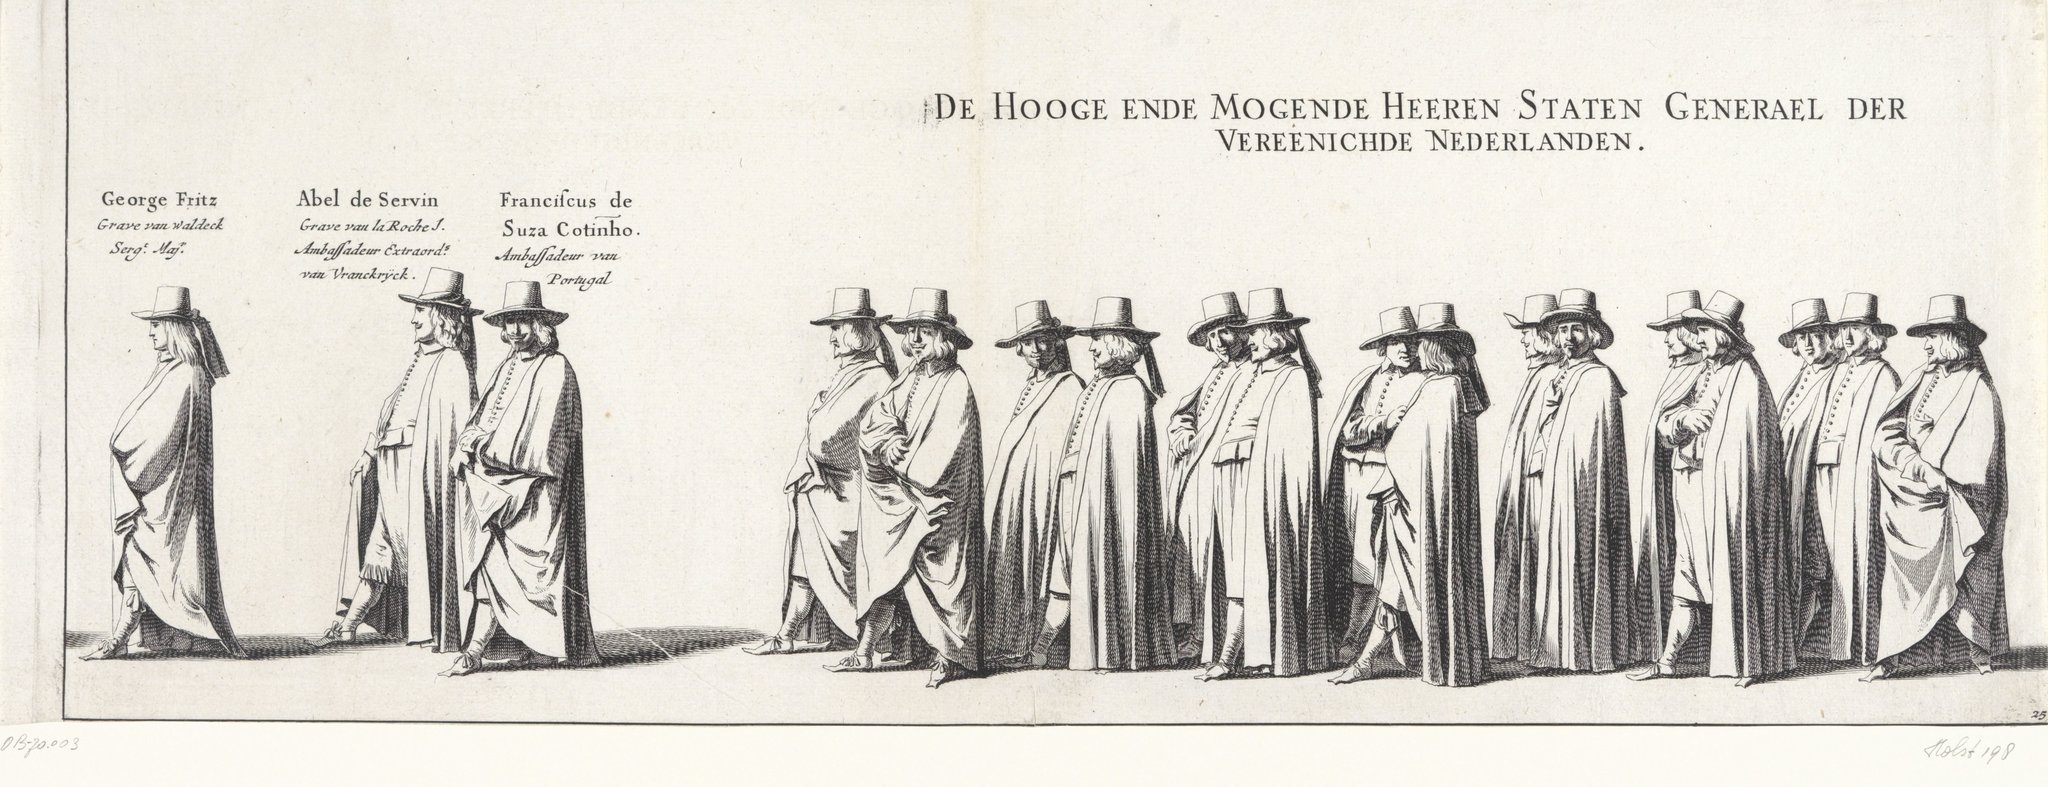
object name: print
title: De begrafenisstoet van Frederik Hendrik (plaat nr. 25), 1647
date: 1647-1651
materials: paper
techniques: etching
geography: amsterdam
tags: delft, the hague, frederick henry (prince of orange), cortege, funeral procession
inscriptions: collector's mark: Lugt 2228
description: De begrafenisstoet van stadhouder Frederik Hendrik te 's-Gravenhage op 10 mei 1647. Plaat nr. 25 met een deel van de stoet met leden van de Staten-Generaal, boven de personen staat hun functie. Onderdeel van een serie van 30 platen en 20 tekstbladen, bedoeld om aan elkaar geplakt te worden.